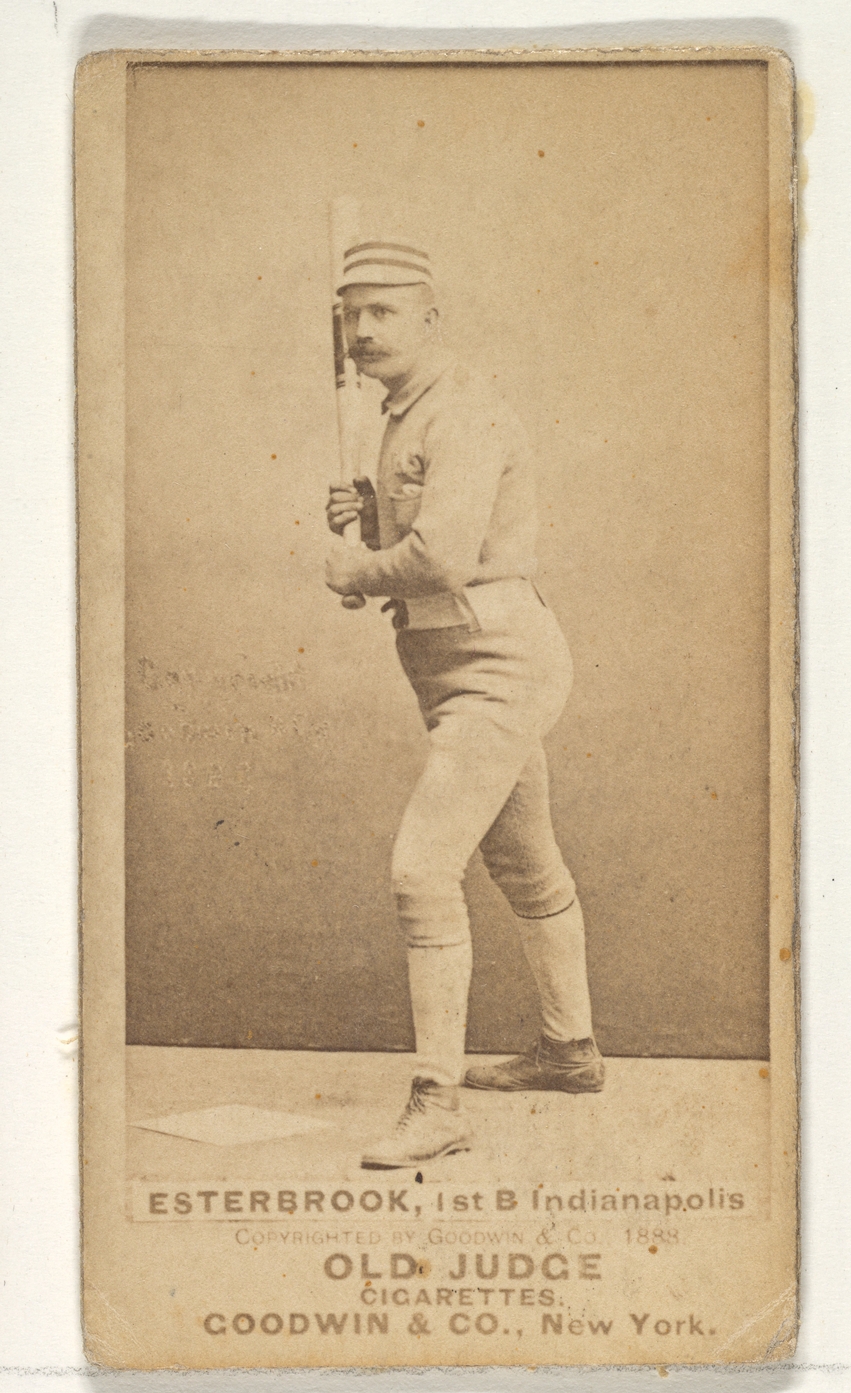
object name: baseball card, photograph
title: Esterbrook, 1st Base, Indianapolis, from the Old Judge series (N172) for Old Judge Cigarettes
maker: goodwin & company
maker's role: publisher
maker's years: 1850-1950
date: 1888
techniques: albumen silver print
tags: men,portraits,baseball,athletes